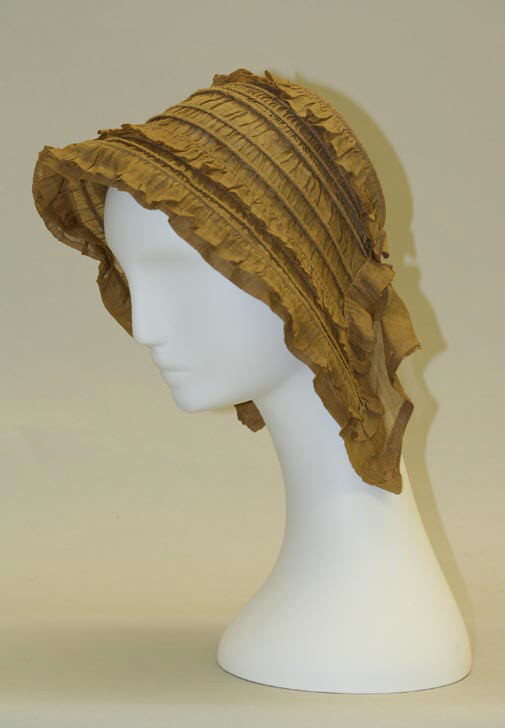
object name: bonnet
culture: american or european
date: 1845-1850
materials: cotton